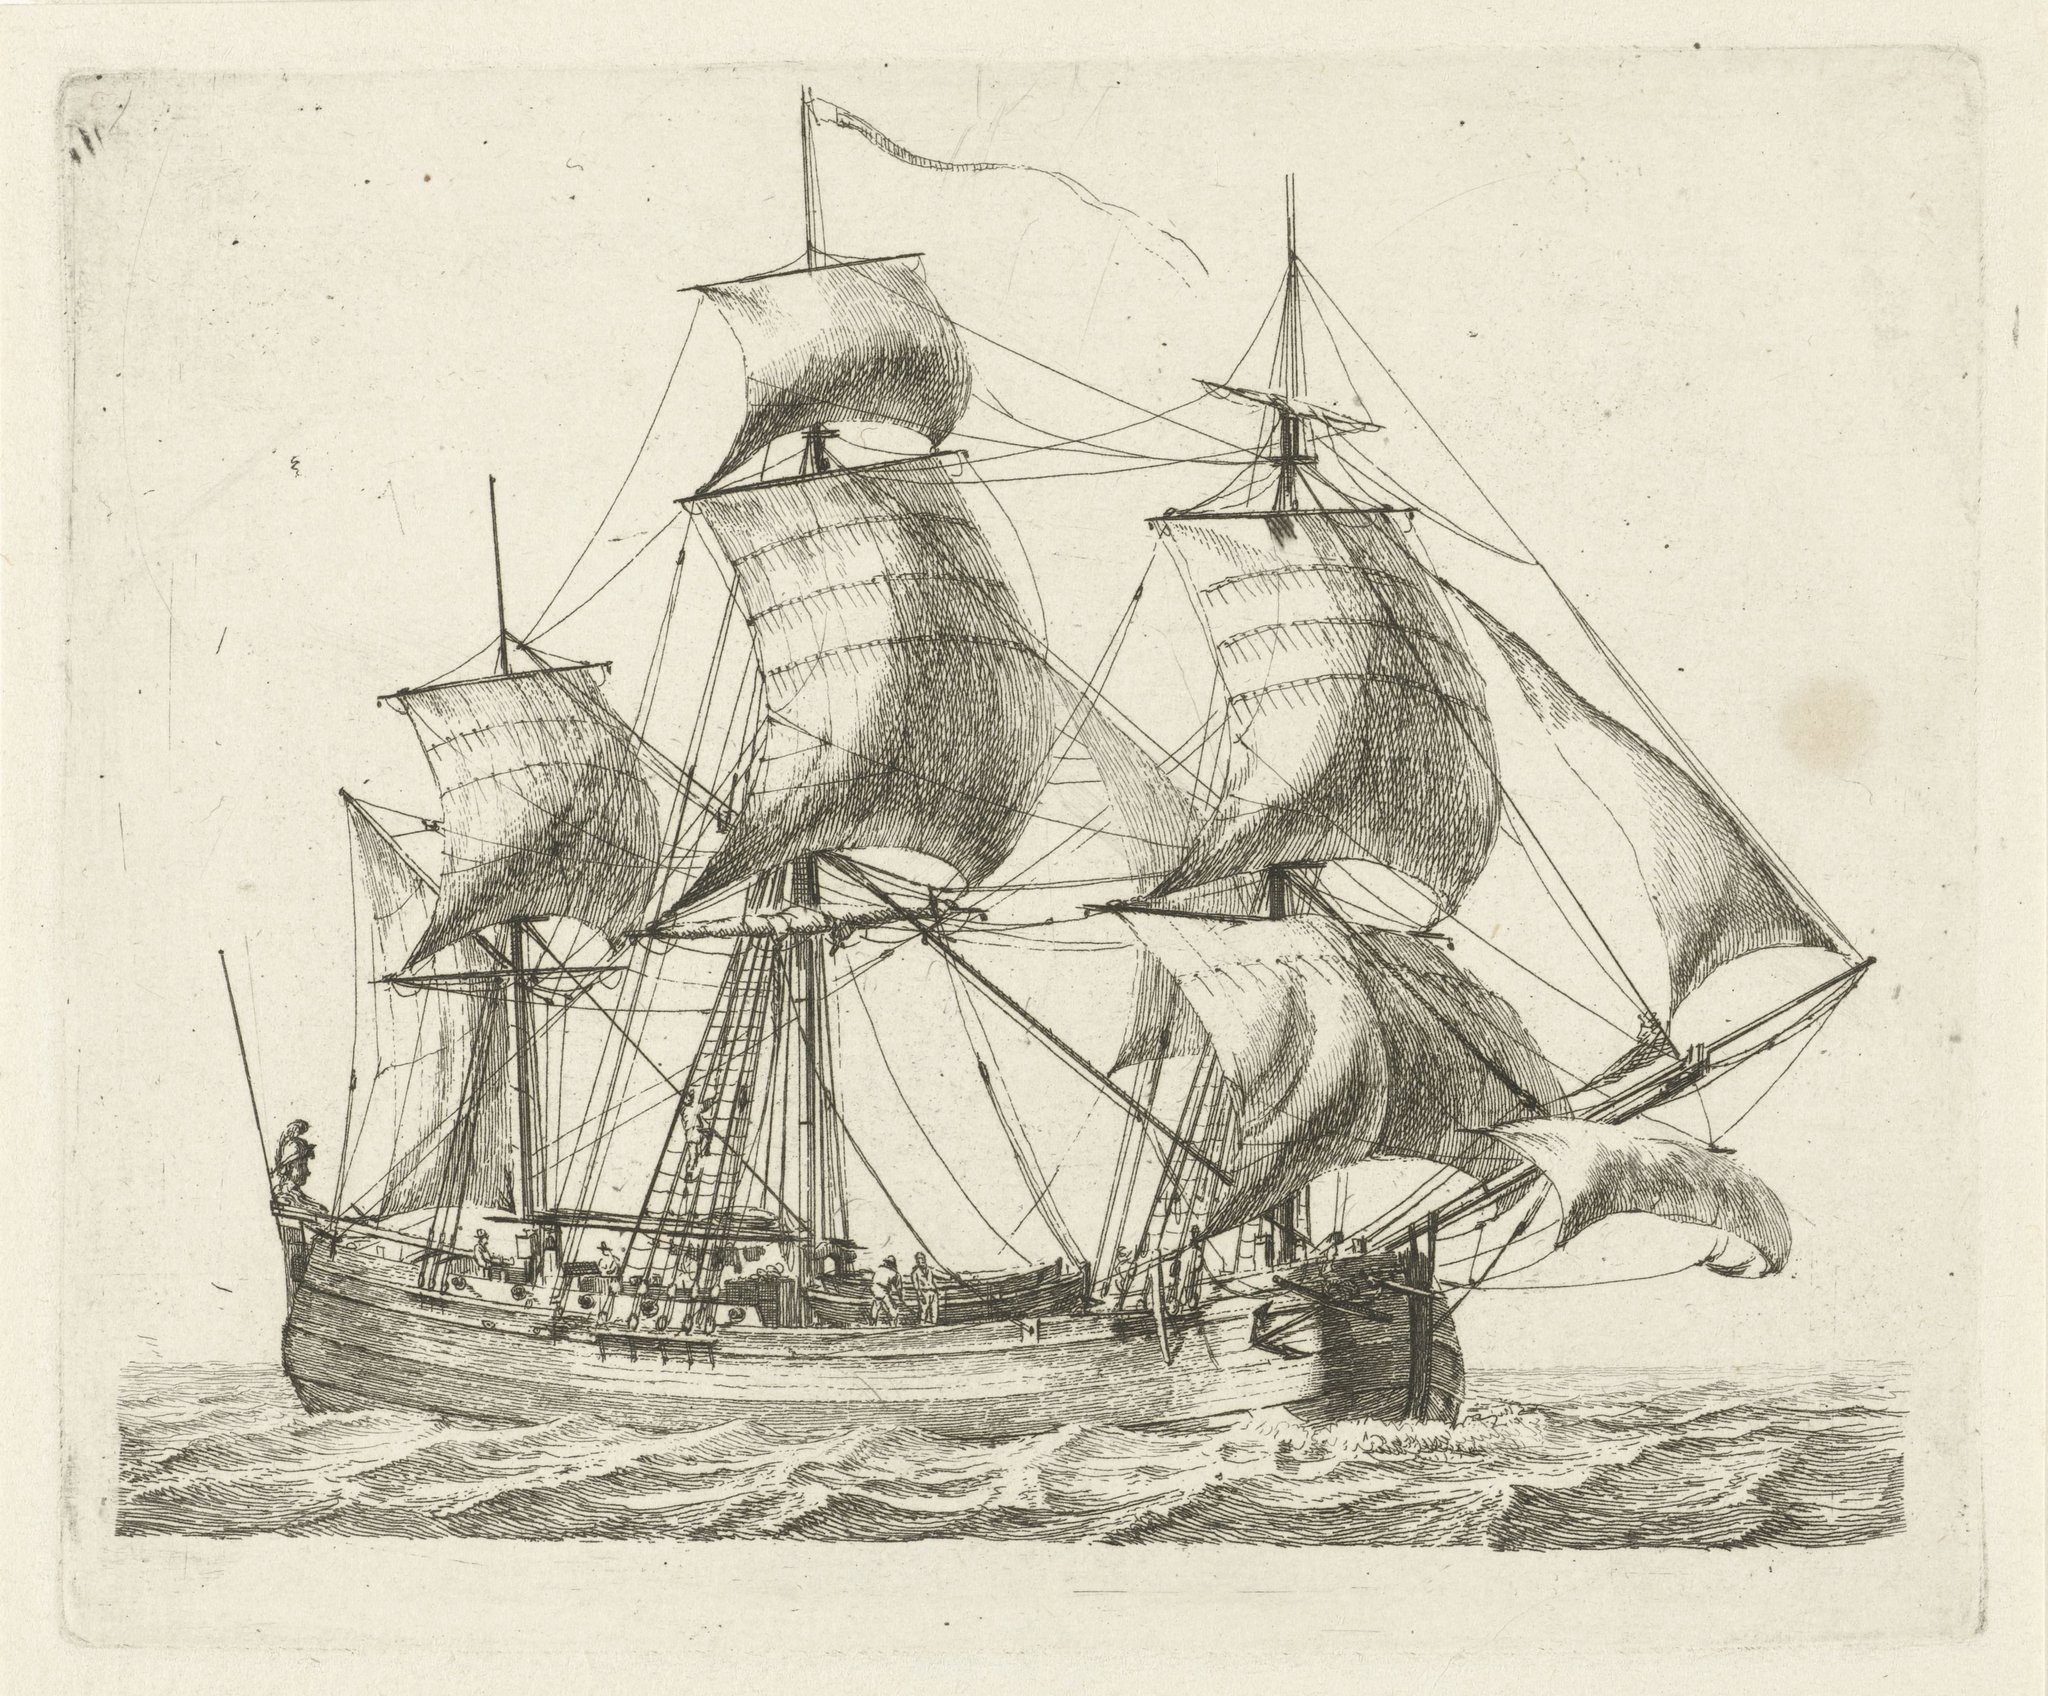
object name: print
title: Verschillende schepen serie C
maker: gerrit groenewegen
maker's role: draughtsman, print maker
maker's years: 1754-1826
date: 1789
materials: paper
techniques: etching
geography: rotterdam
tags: ships (in general)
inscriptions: collector's mark: Lugt 2228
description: Driemaster met de wind in de zeilen, naar rechts varend. Op het dek ligt een sloep en zijn enkele figuren afgebeeld. Deze prent maakt deel uit van een serie van twaalf prenten met verschillende zeilschepen.